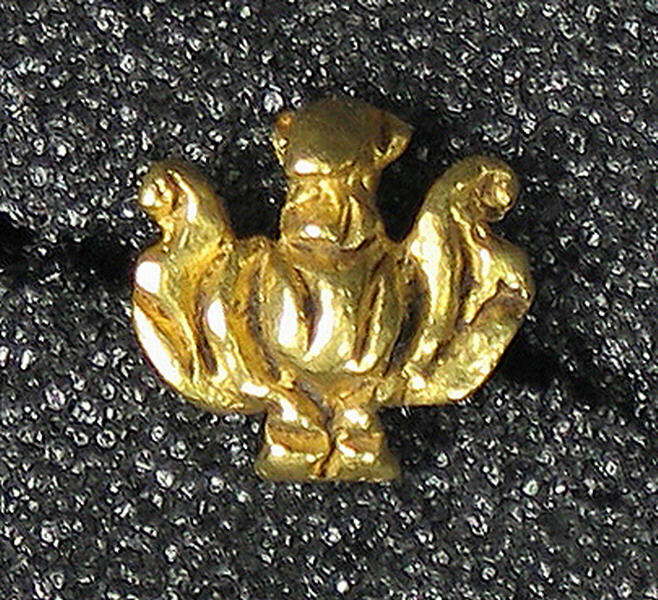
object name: earring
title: Bird-Form Earring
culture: indonesian, central java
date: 701-1200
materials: gold